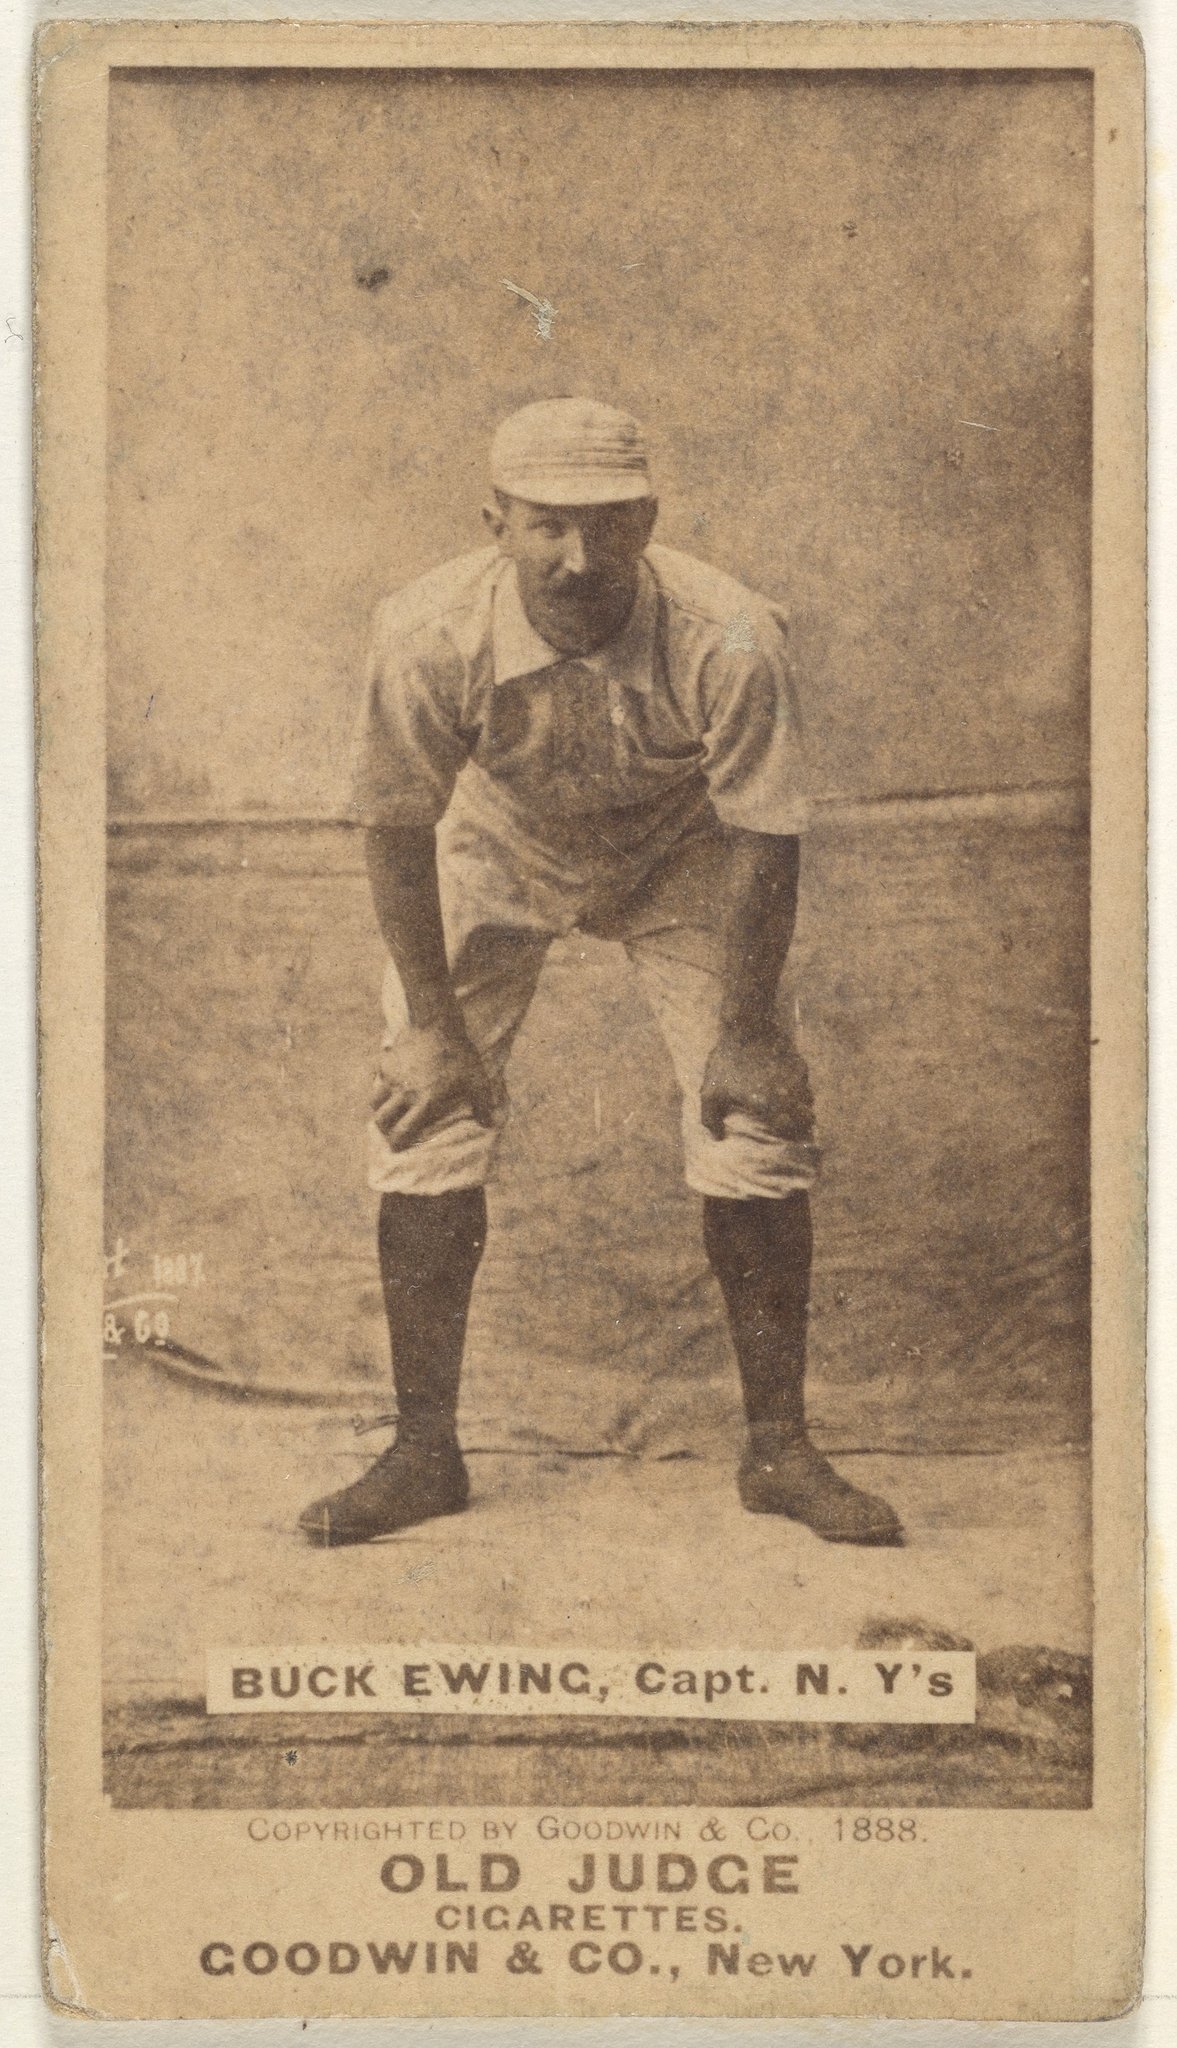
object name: baseball card, photograph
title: William "Buck" Ewing, Captain and Catcher, New York, from the Old Judge series (N172) for Old Judge Cigarettes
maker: goodwin & company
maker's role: publisher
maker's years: 1850-1950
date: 1888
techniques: albumen silver print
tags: men,portraits,baseball,athletes